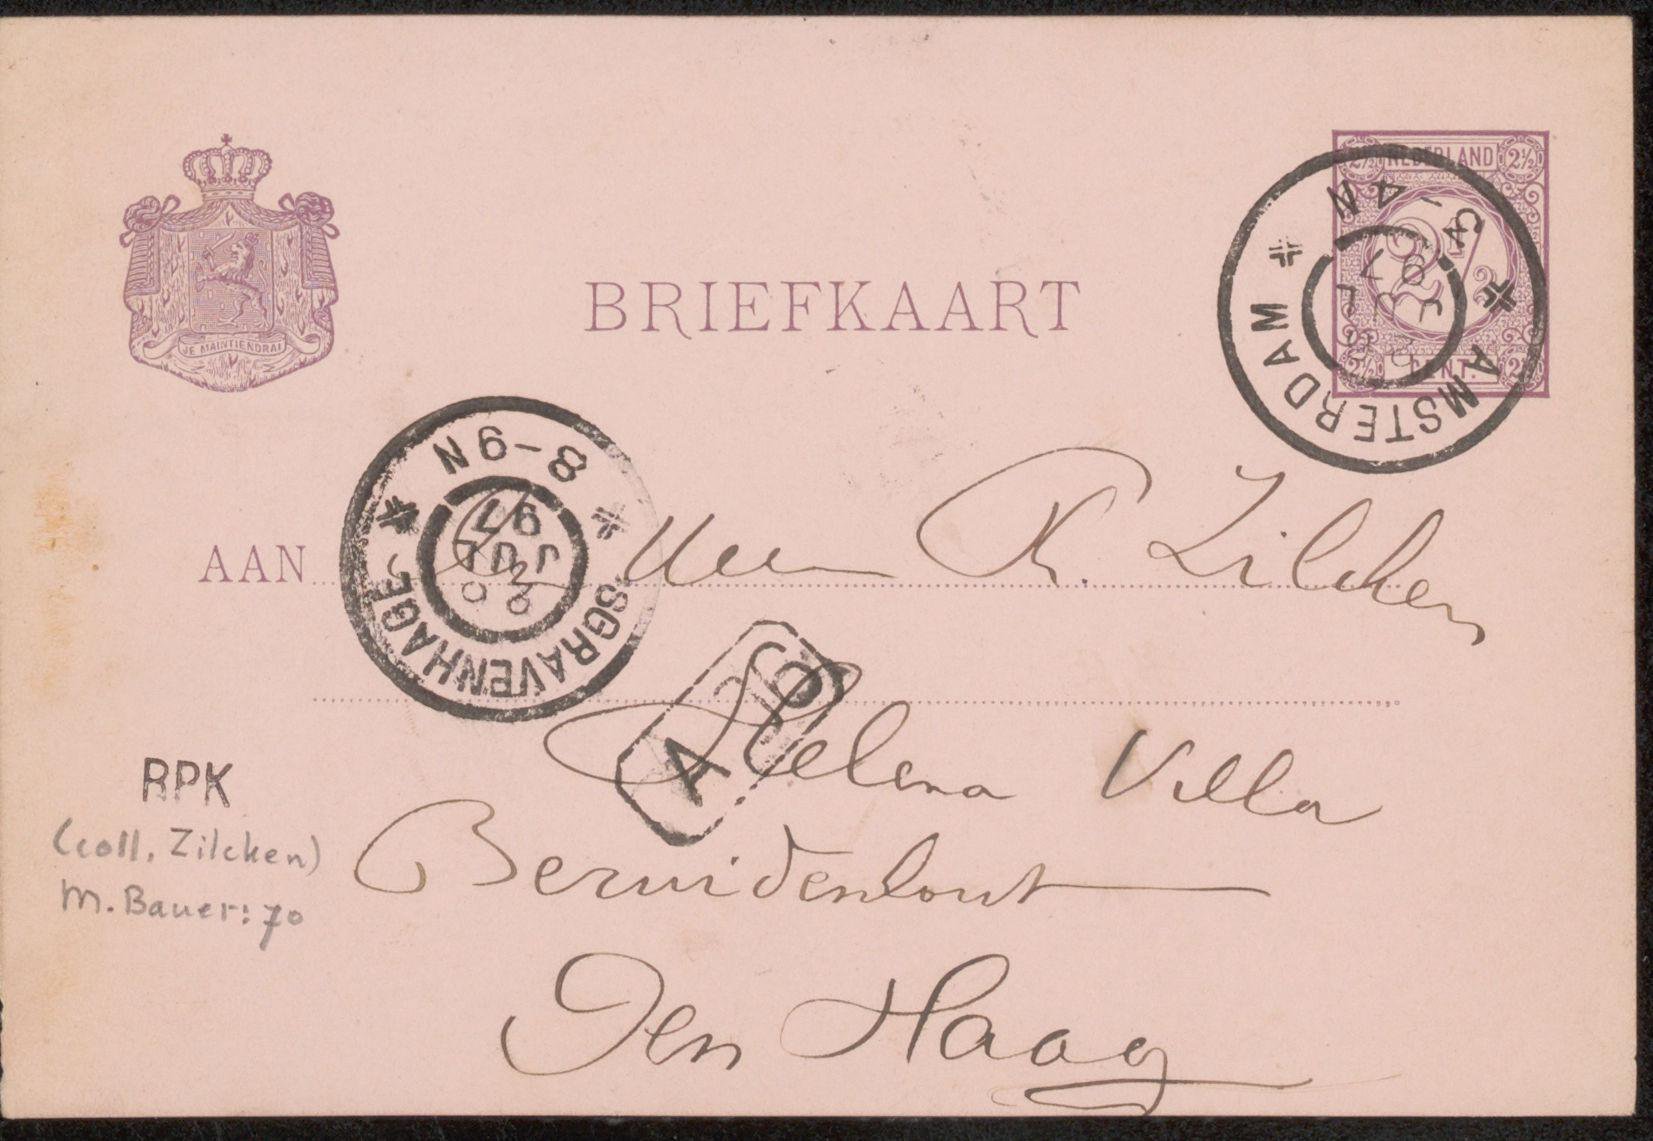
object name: postcard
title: Briefkaart aan Philip Zilcken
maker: marius bauer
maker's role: draughtsman, print maker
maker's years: 1867-1932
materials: cardboard, ink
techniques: pen, writing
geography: amsterdam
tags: klaas groesbeek, the hague, painter, draughtsman, philip zilcken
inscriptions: collector's mark: ‘RPK’